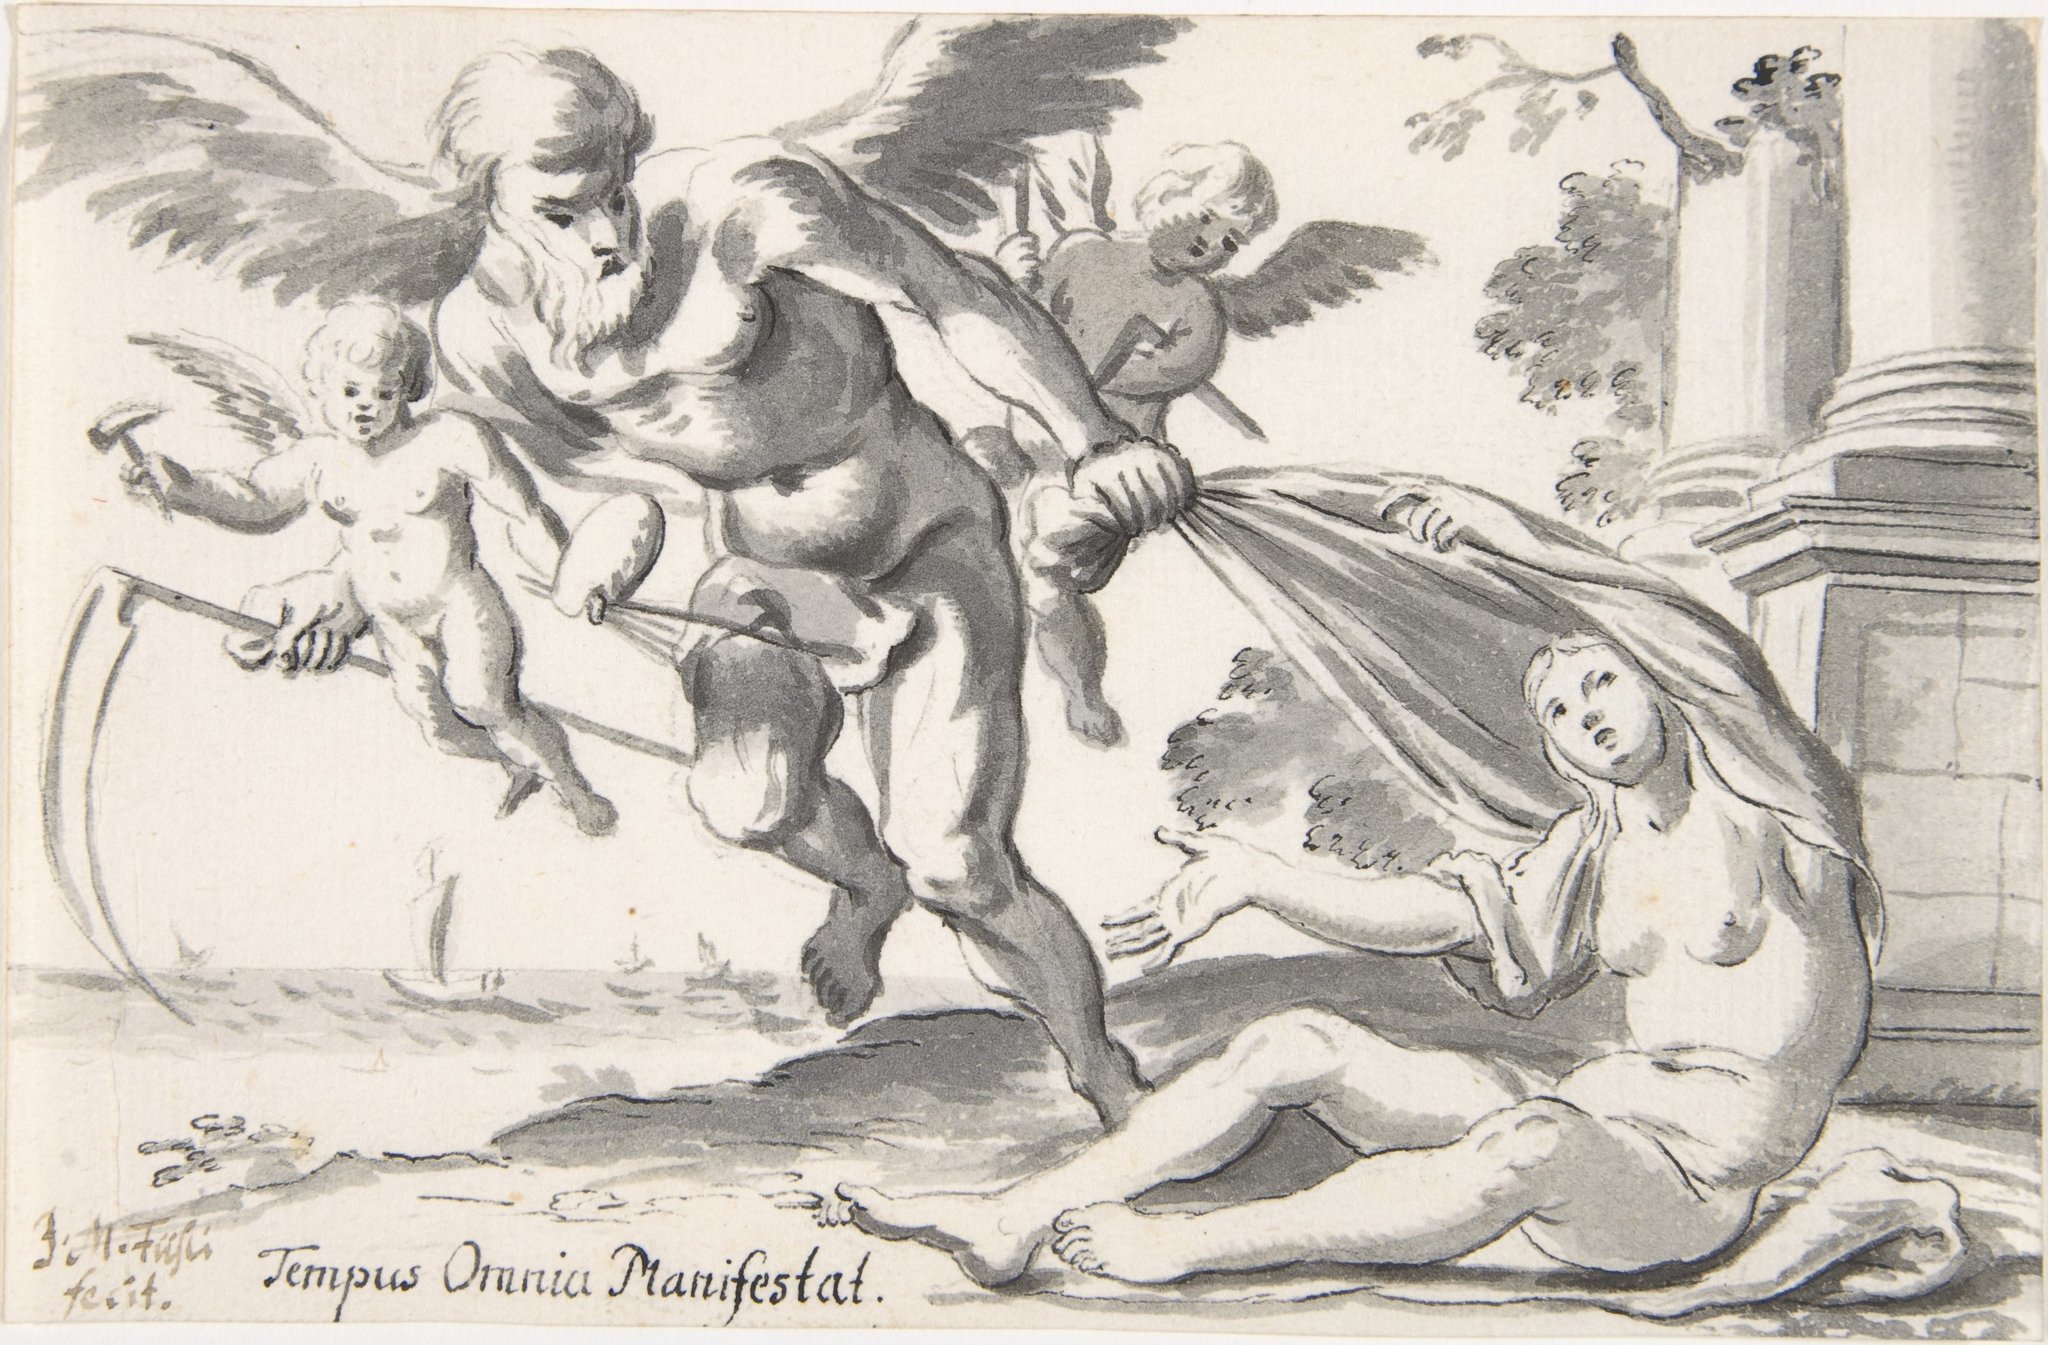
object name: drawing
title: 'Tempus omnia manifestat': Allegory of Art and Knowledge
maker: johann melchior füssli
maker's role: artist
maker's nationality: swiss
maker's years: 1677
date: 1667-1733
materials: ink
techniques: brush, pen, wash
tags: female nudes